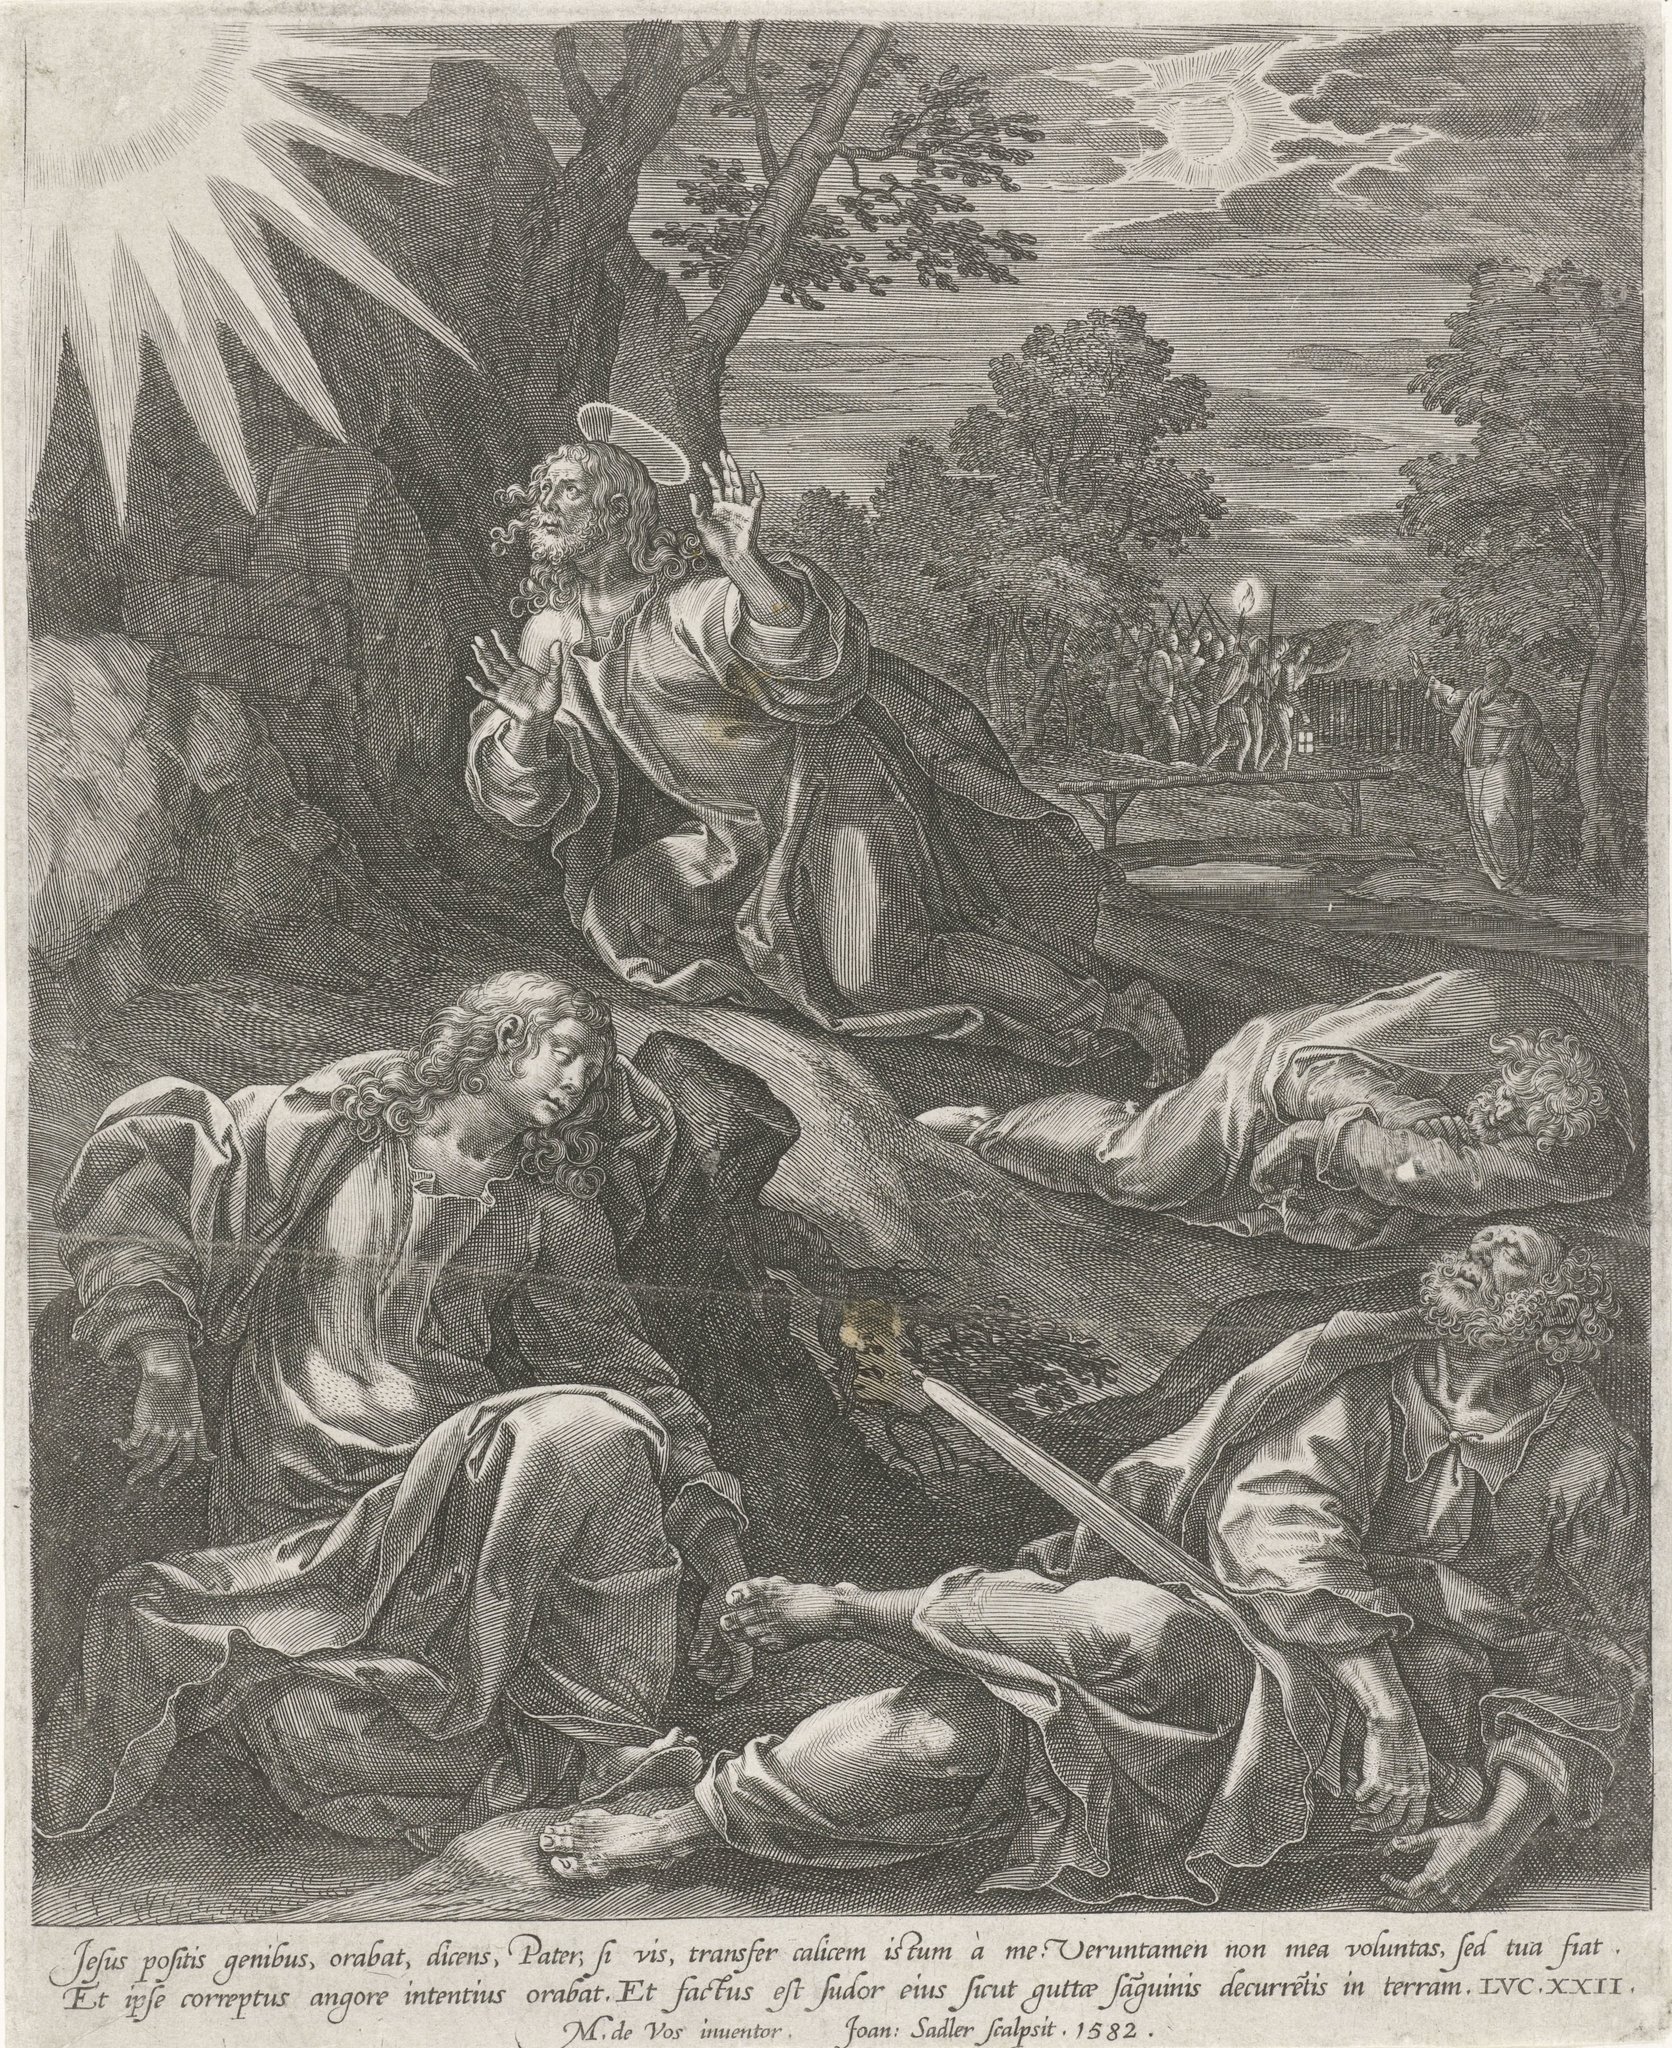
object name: print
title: Passio et Resurrectio D.N. Iesu Christi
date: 1582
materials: paper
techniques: engraving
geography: antwerp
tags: christ's prayer in the garden of gethsemane during the night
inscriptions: collector's mark: Lugt 2228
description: De biddende Christus en de slapende apostelen in de tuin van Getsemane. In de linkerbovenhoek een lichtstraal. Op de achtergrond komt Judas met de soldaten Getsemane binnen. De prent heeft een Latijns onderschrift met een tekst uit de Bijbel en is de tweede prent van een veertiendelige serie over de passie van Christus.